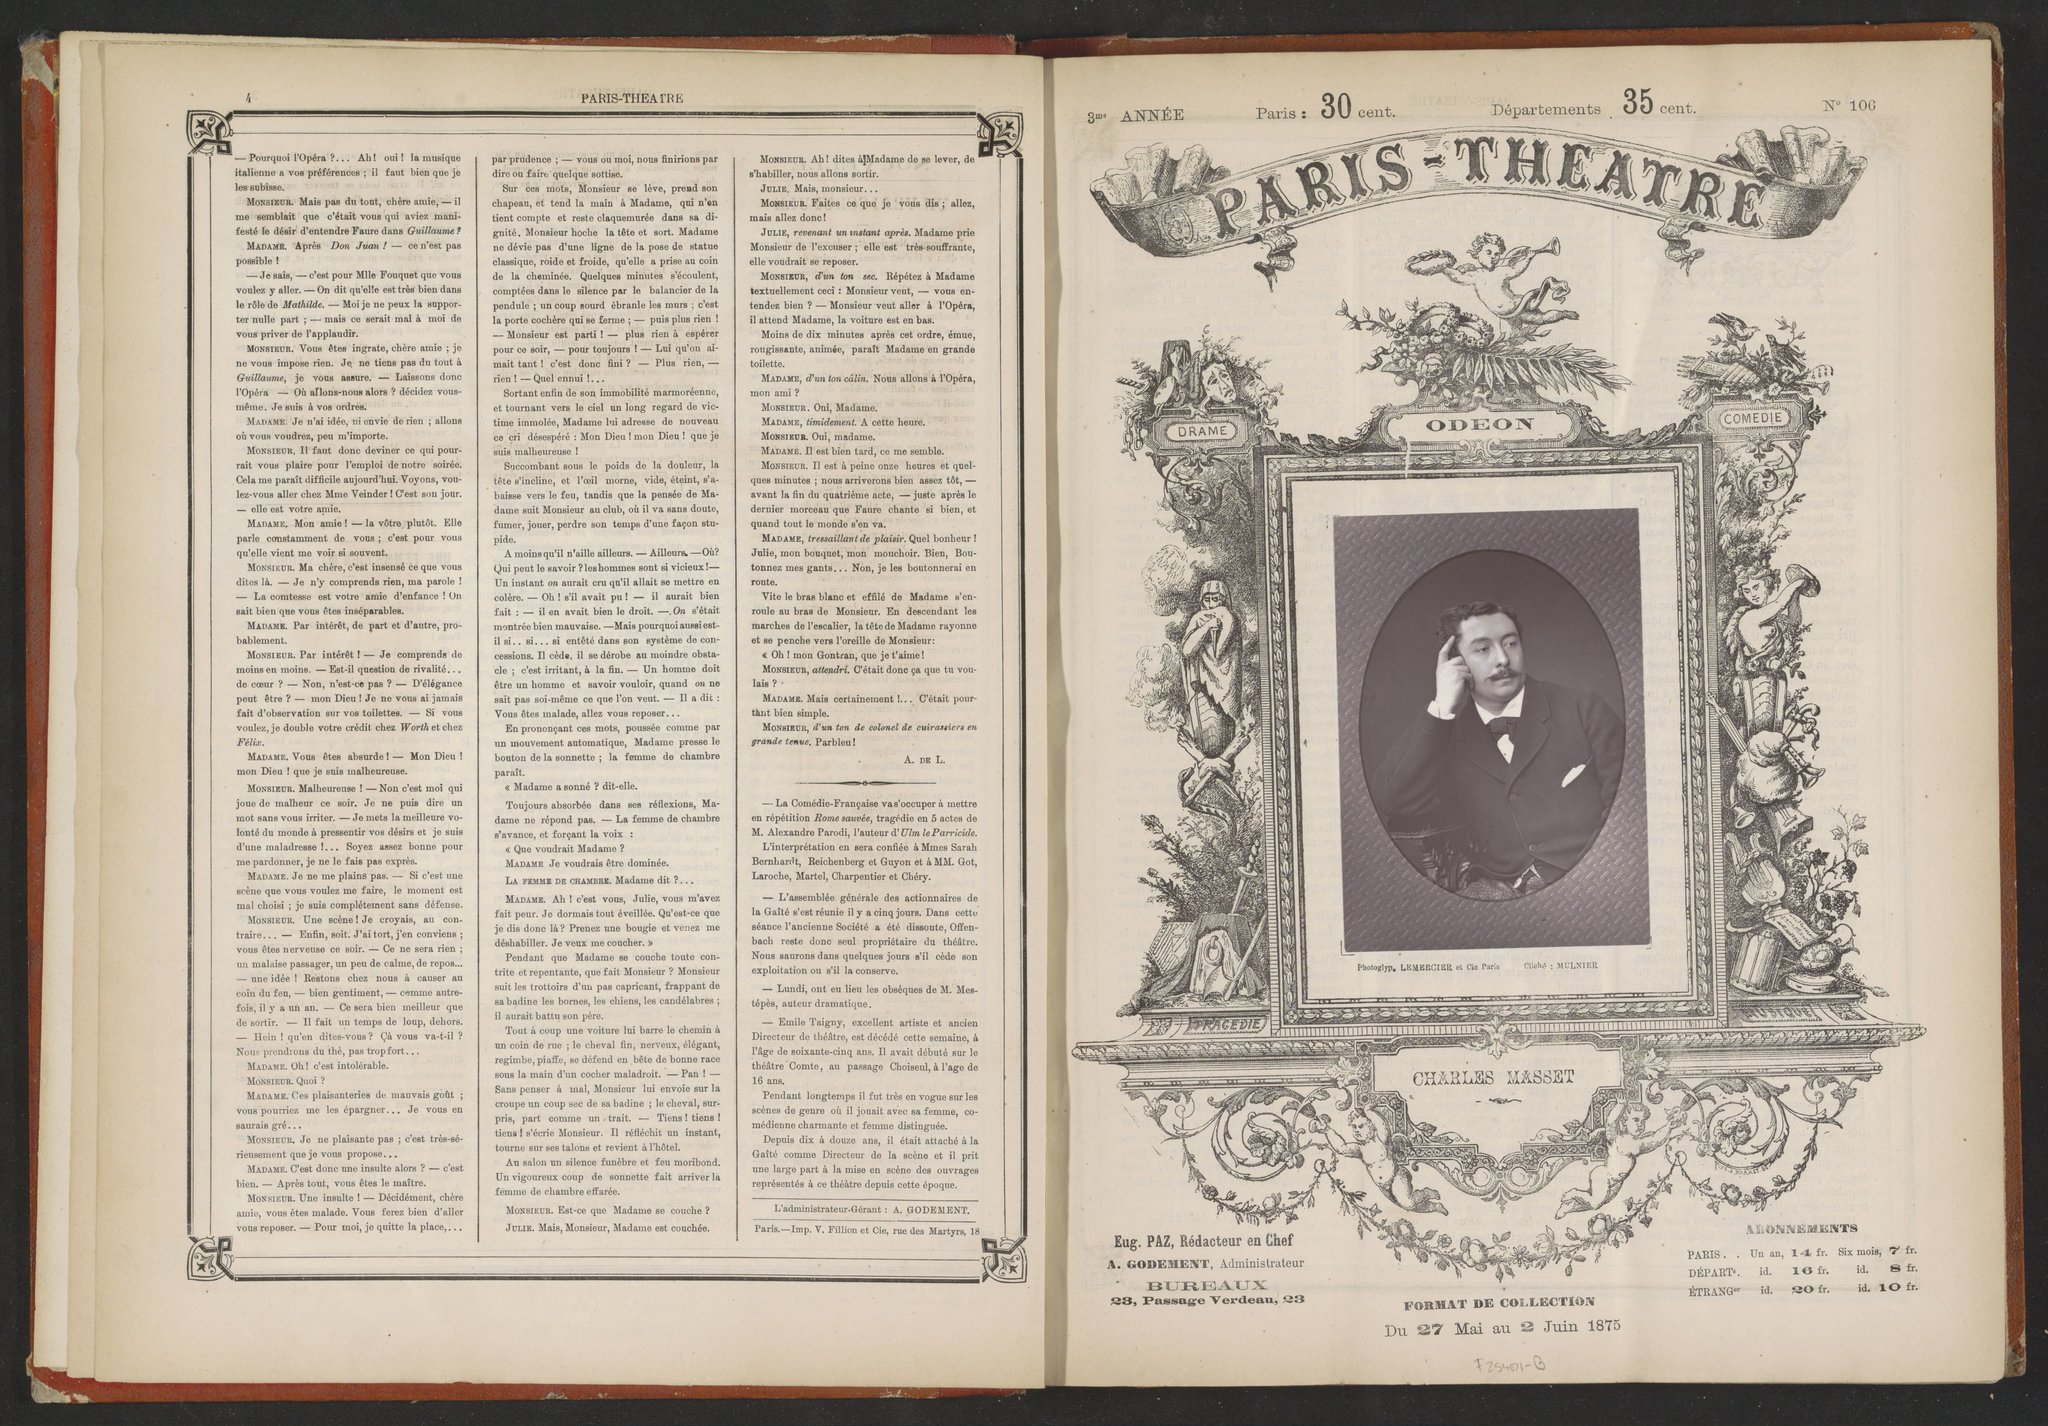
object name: page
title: Charles Masset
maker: ferdinand mulnier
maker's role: painter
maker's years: 1817-1891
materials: paper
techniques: woodburytype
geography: paris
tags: portrait of opera-singer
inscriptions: number: ‘No 106’, inscription: ‘Du 27Mai au 2 Juin 1875’